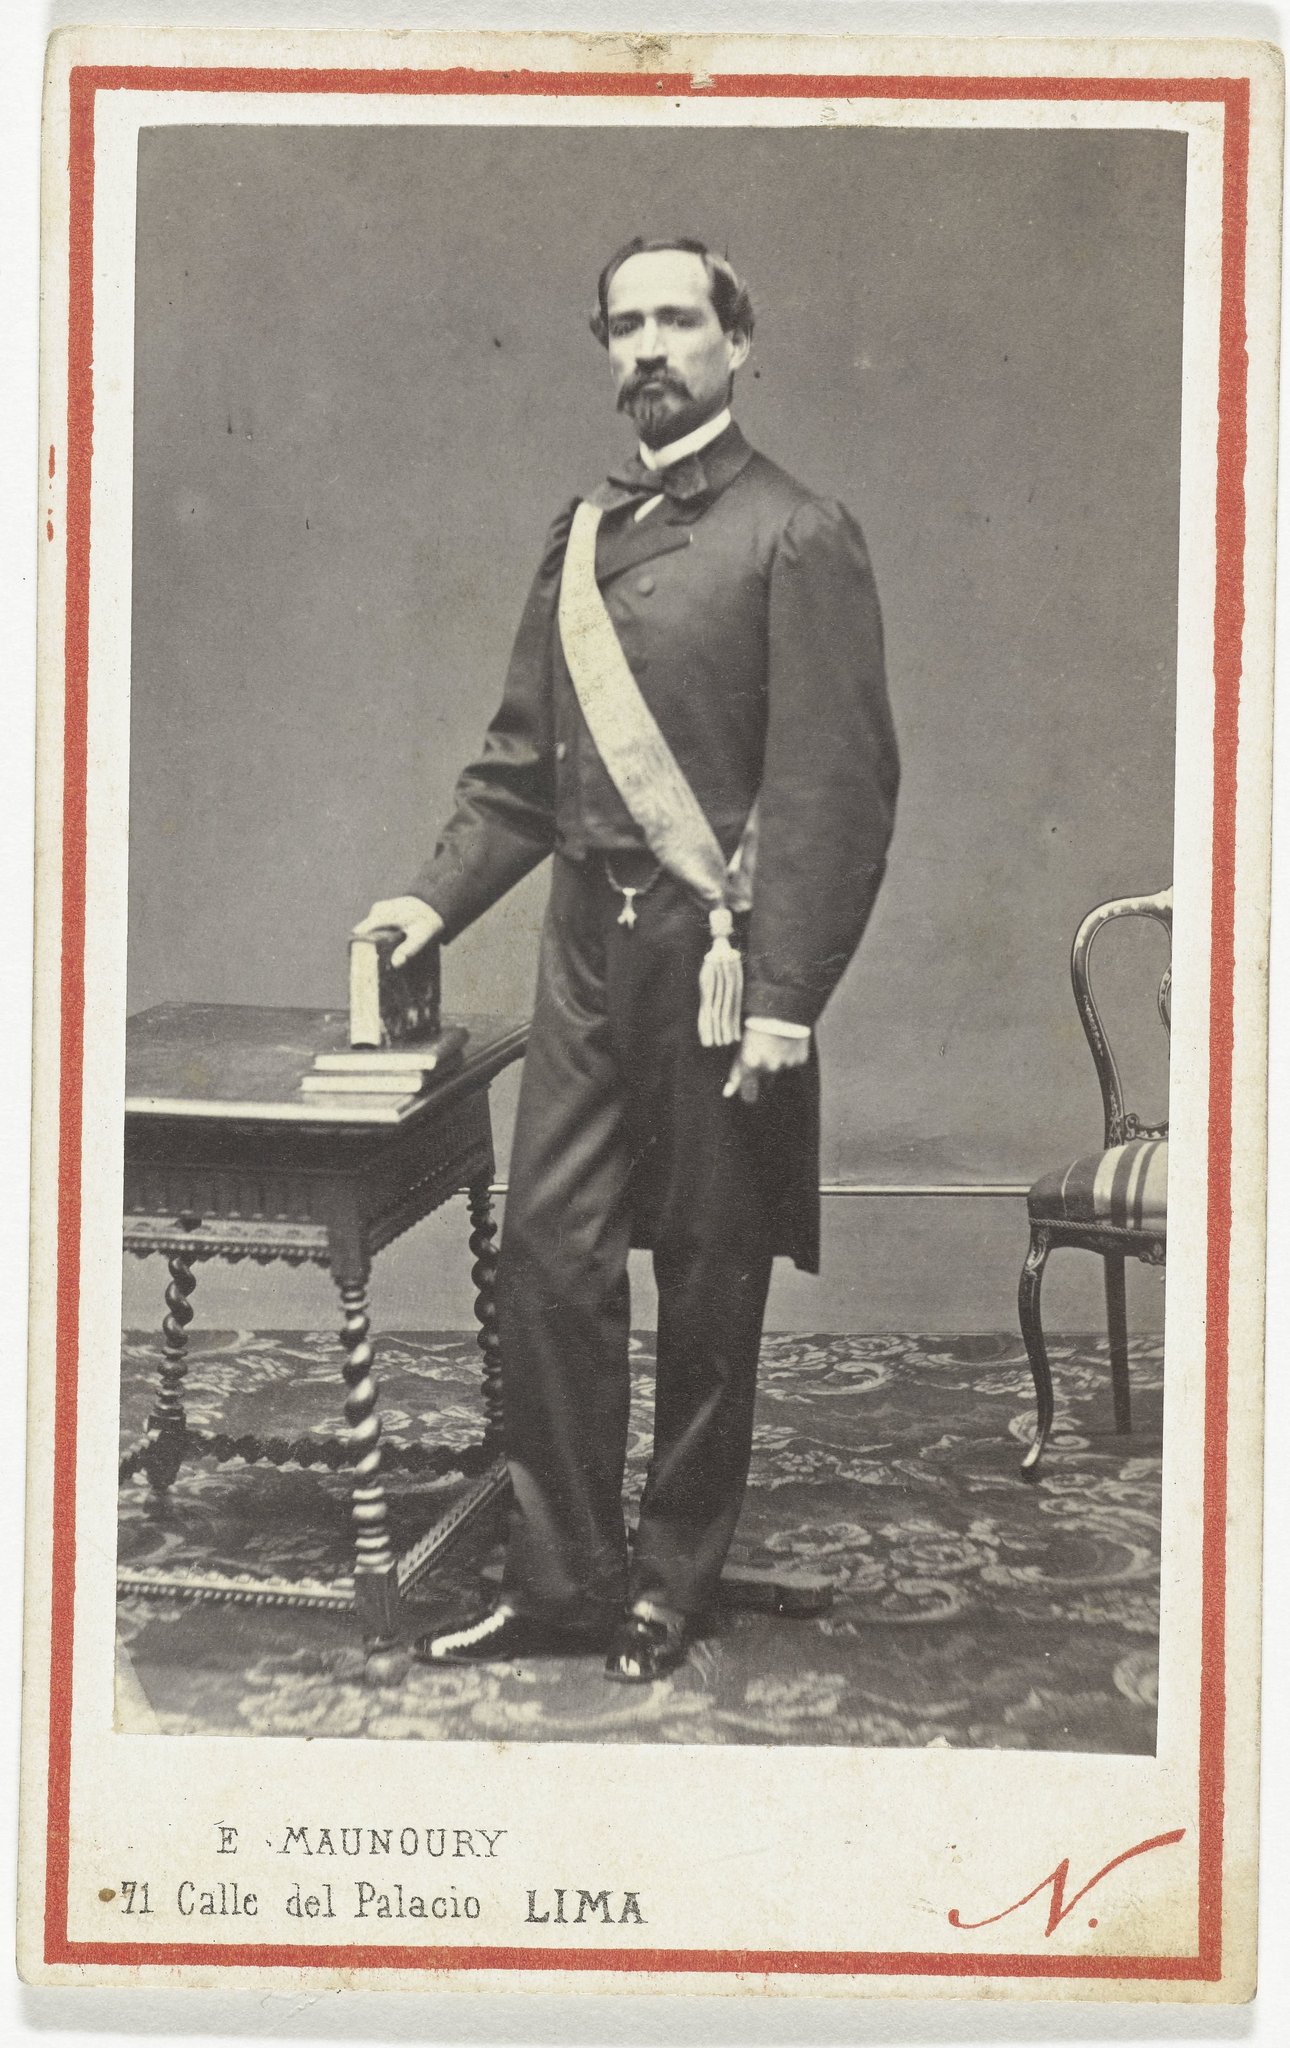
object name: photograph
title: Portret van een onbekende man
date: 1860-1865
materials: cardboard, photographic support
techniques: albumen print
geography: paris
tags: historical persons not known by name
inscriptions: name: ‘José Ja[...]to Hana’, inscription: ‘E. MAUNOURY/ Corresponsal de la Casa’, name: ‘Nadar/ DE PARIS’, address: ‘E. MAUNOURY/ 71, Calle del Palacio LIMA/ N.’